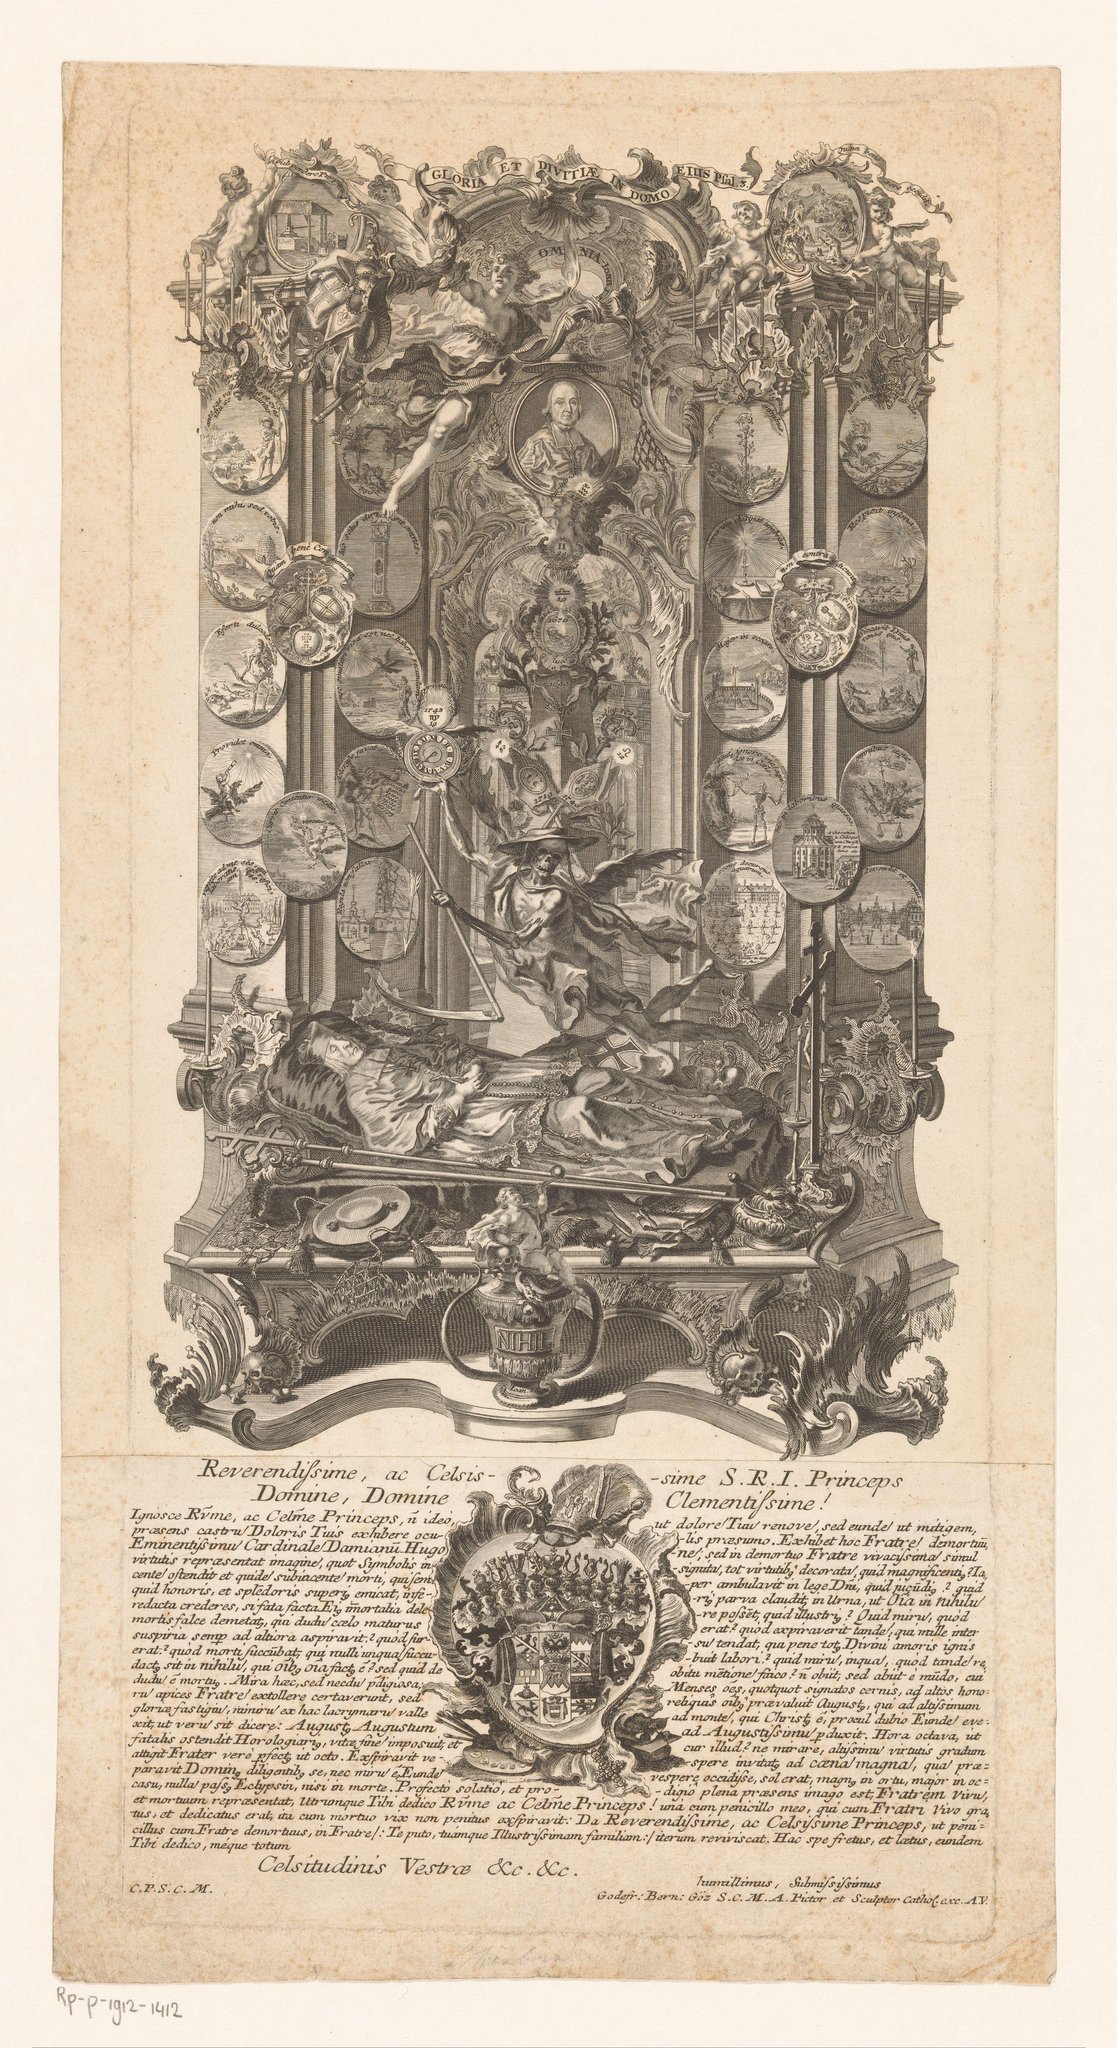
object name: print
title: Allegorie op het overlijden van Damian Hugo Philipp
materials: paper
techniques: engraving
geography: augsburg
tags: rocaille ornament, death as skeleton (+ death with scythe), insignia of bishop, e.g. mitre, crozier, historical persons, 'vanitas' symbols, zodiac; the twelve zodiacal signs together, abstract ideas and concepts (+ emblematical representation of concept), lying in state, armorial bearing, heraldry, death of human being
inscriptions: collector's mark: Lugt 2228